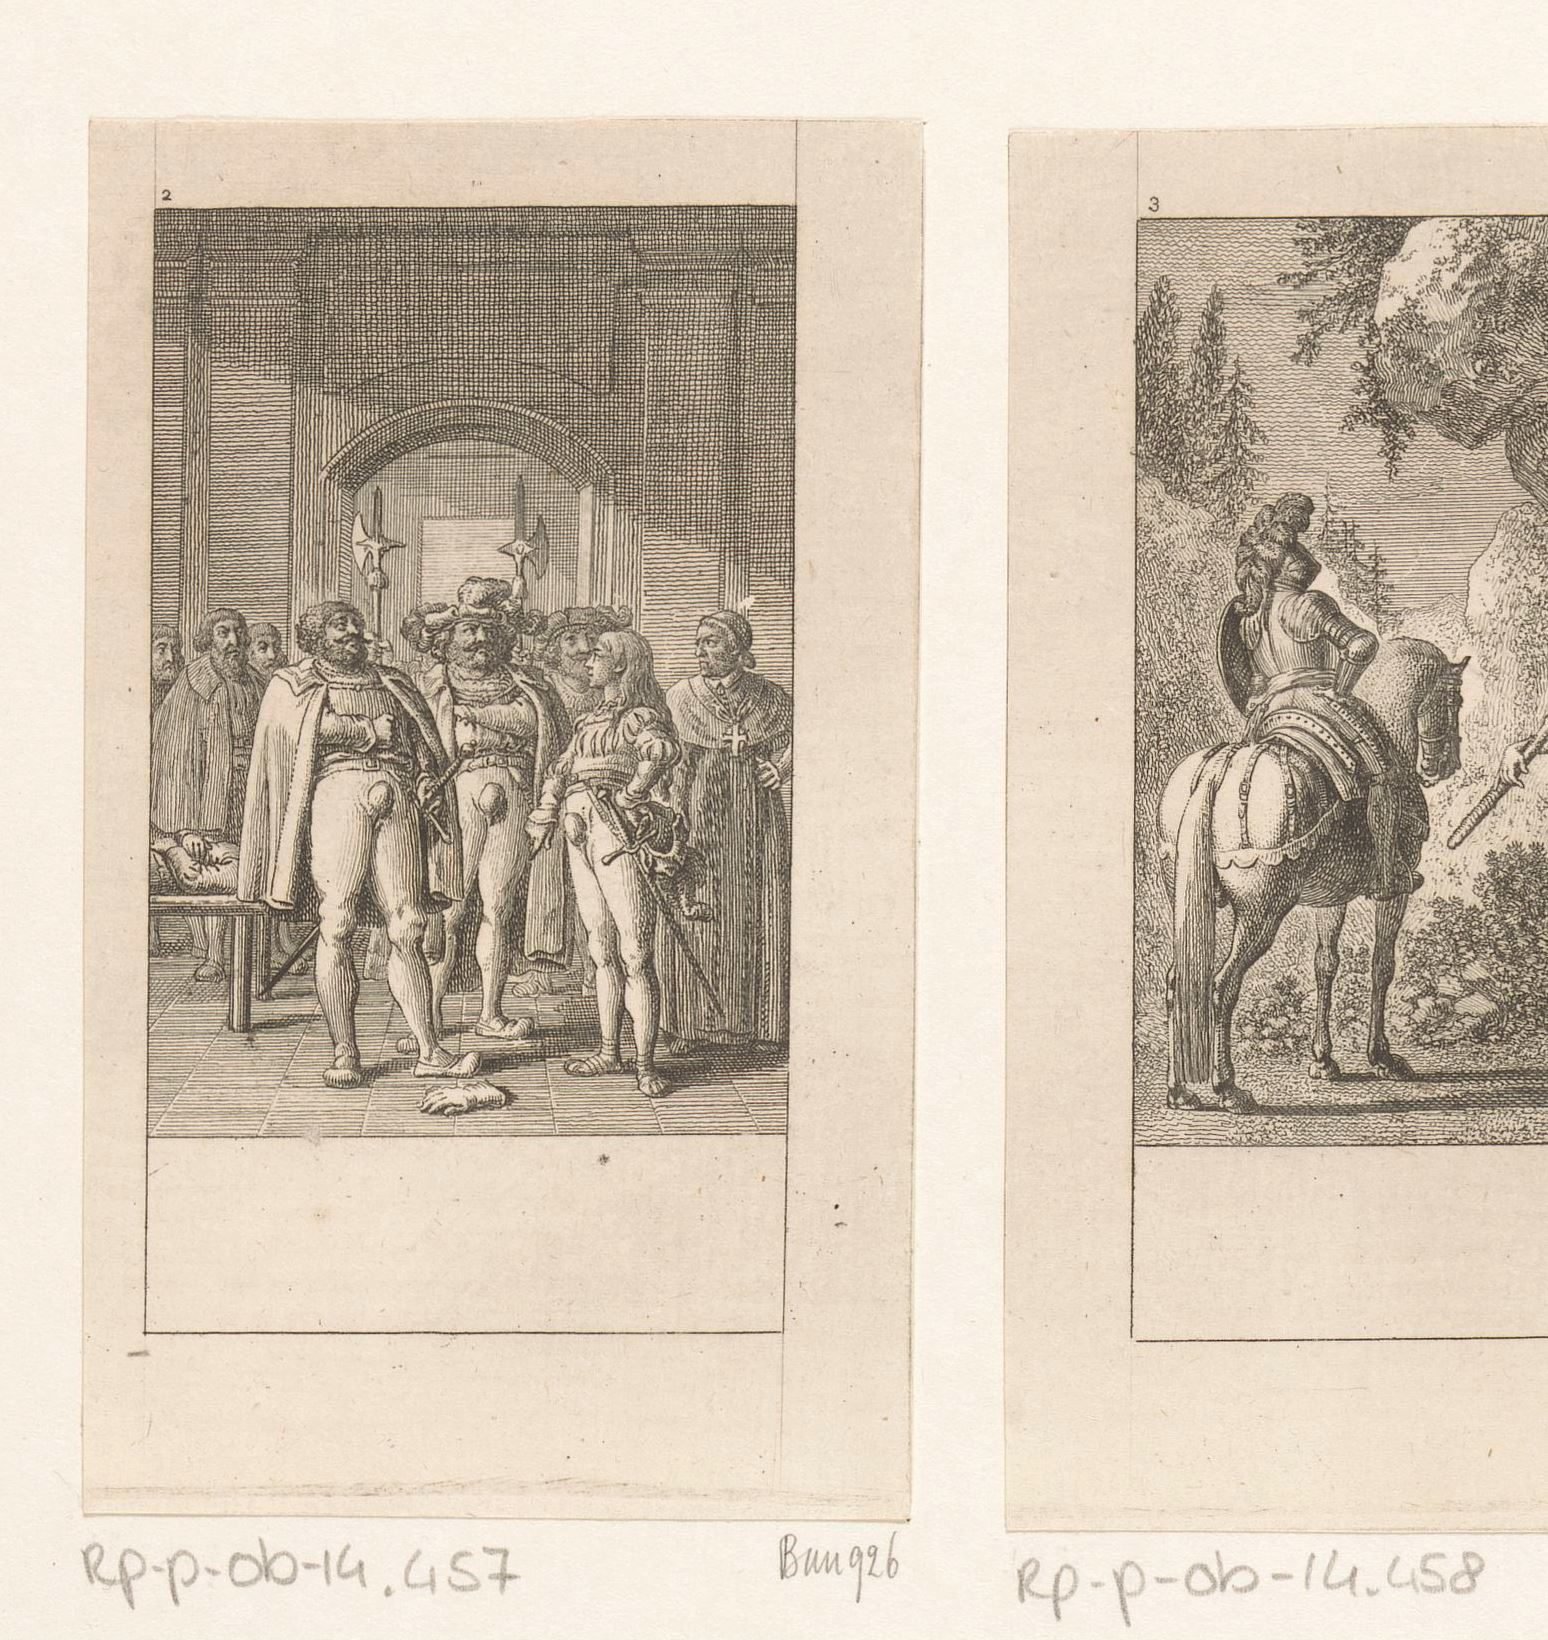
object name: print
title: Keizer Karl daagt Huon de Bordeaux uit voor een duel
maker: daniel nikolaus chodowiecki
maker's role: draughtsman, print maker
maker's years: 1726-1801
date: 1782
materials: paper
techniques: etching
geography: berlin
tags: gloves, mittens, etc., duelling, death of human being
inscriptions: collector's mark: Lugt 2228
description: Vervaardigd voor Tressans 'Huon de Bordeaux'. Latere staat gebruikt voor: Almanac de Gotha contenant diverses connaissances curieuses et utiles pour l'année MDCCLXXXIII. Gotha: C. W. Ettinger, 1782.